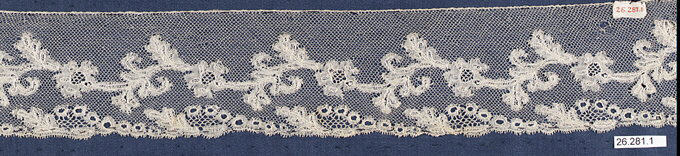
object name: strip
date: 1801-1833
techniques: lace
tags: flowers